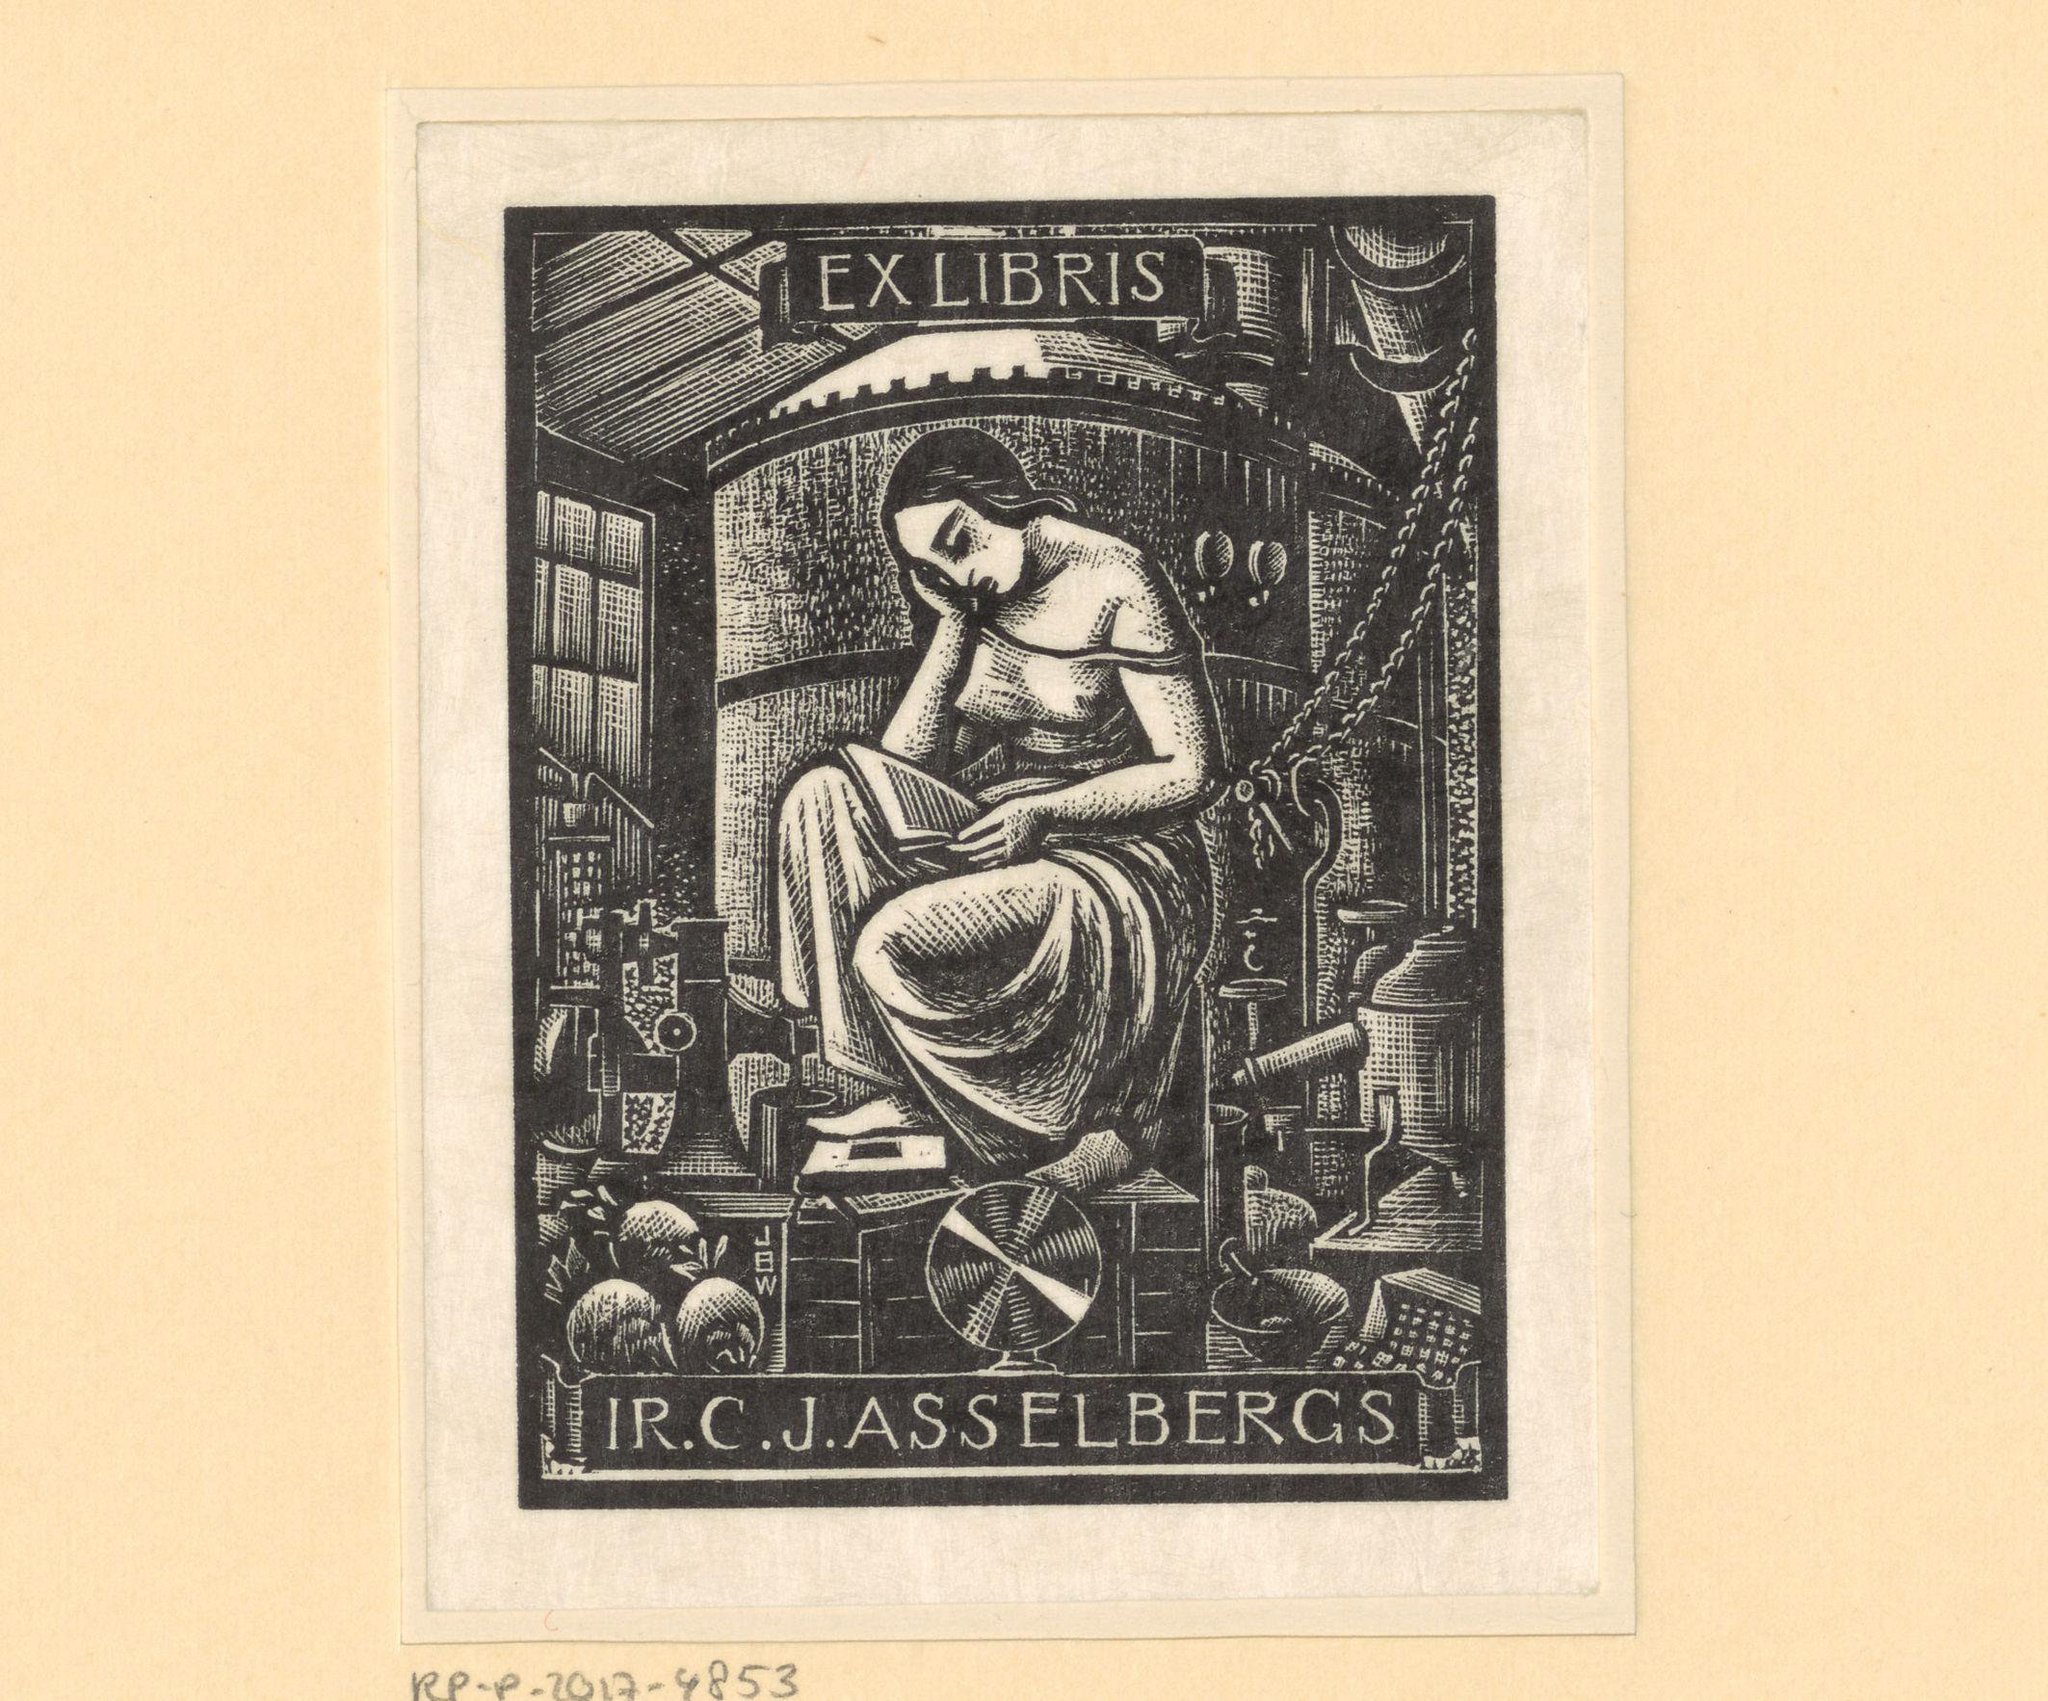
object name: bookplate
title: Ex libris van C.J. Asselbergs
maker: john buckland wright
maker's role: print maker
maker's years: 1897-1954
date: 1933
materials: paper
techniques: engraving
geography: paris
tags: c.j. asselbergs, reading, sitting figure - aa - female human figure, woman (showing herself) undressed, quasi-nude, laboratory, (non-fruit) products of plants or trees: turnip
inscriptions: inscription: ‘John Buckland Wright. Hgr. 1933 / Tent. Konstfackskolan 1951 nr. 142’, inscription: ‘Supermarrée Japansch papier / Houtgravure 1933 / John Buckland Wright / Parijs’